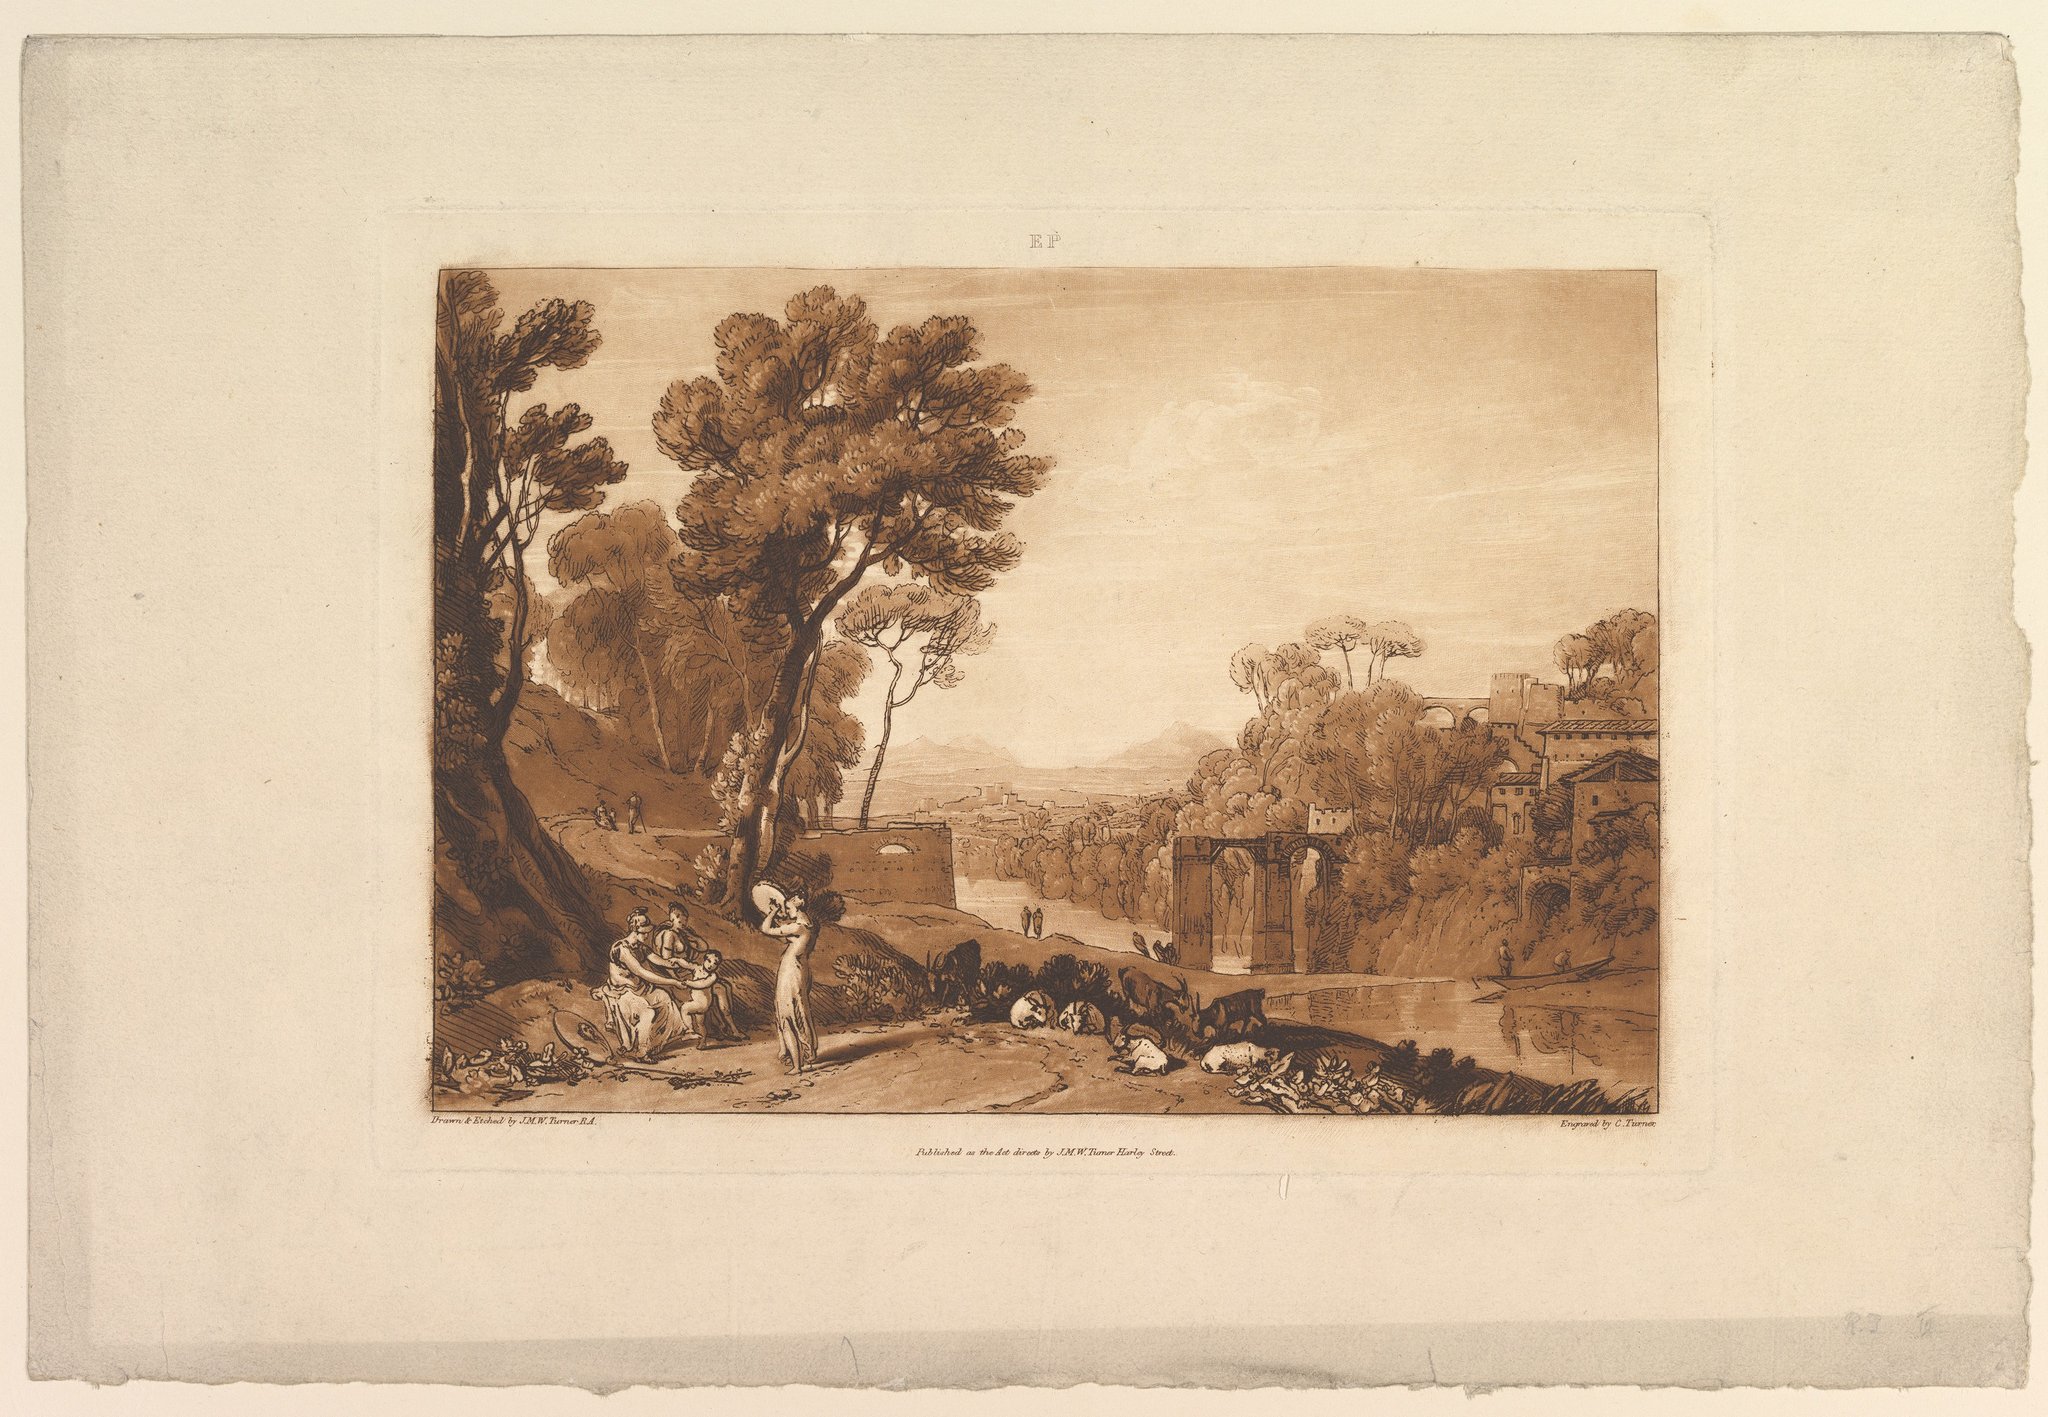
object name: print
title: The Woman and Tambourine, part I, plate 3 from "Liber Studiorum"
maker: joseph mallord william turner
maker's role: artist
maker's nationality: british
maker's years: 1775-1851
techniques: etching, mezzotint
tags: musical instruments,animals,women,trees